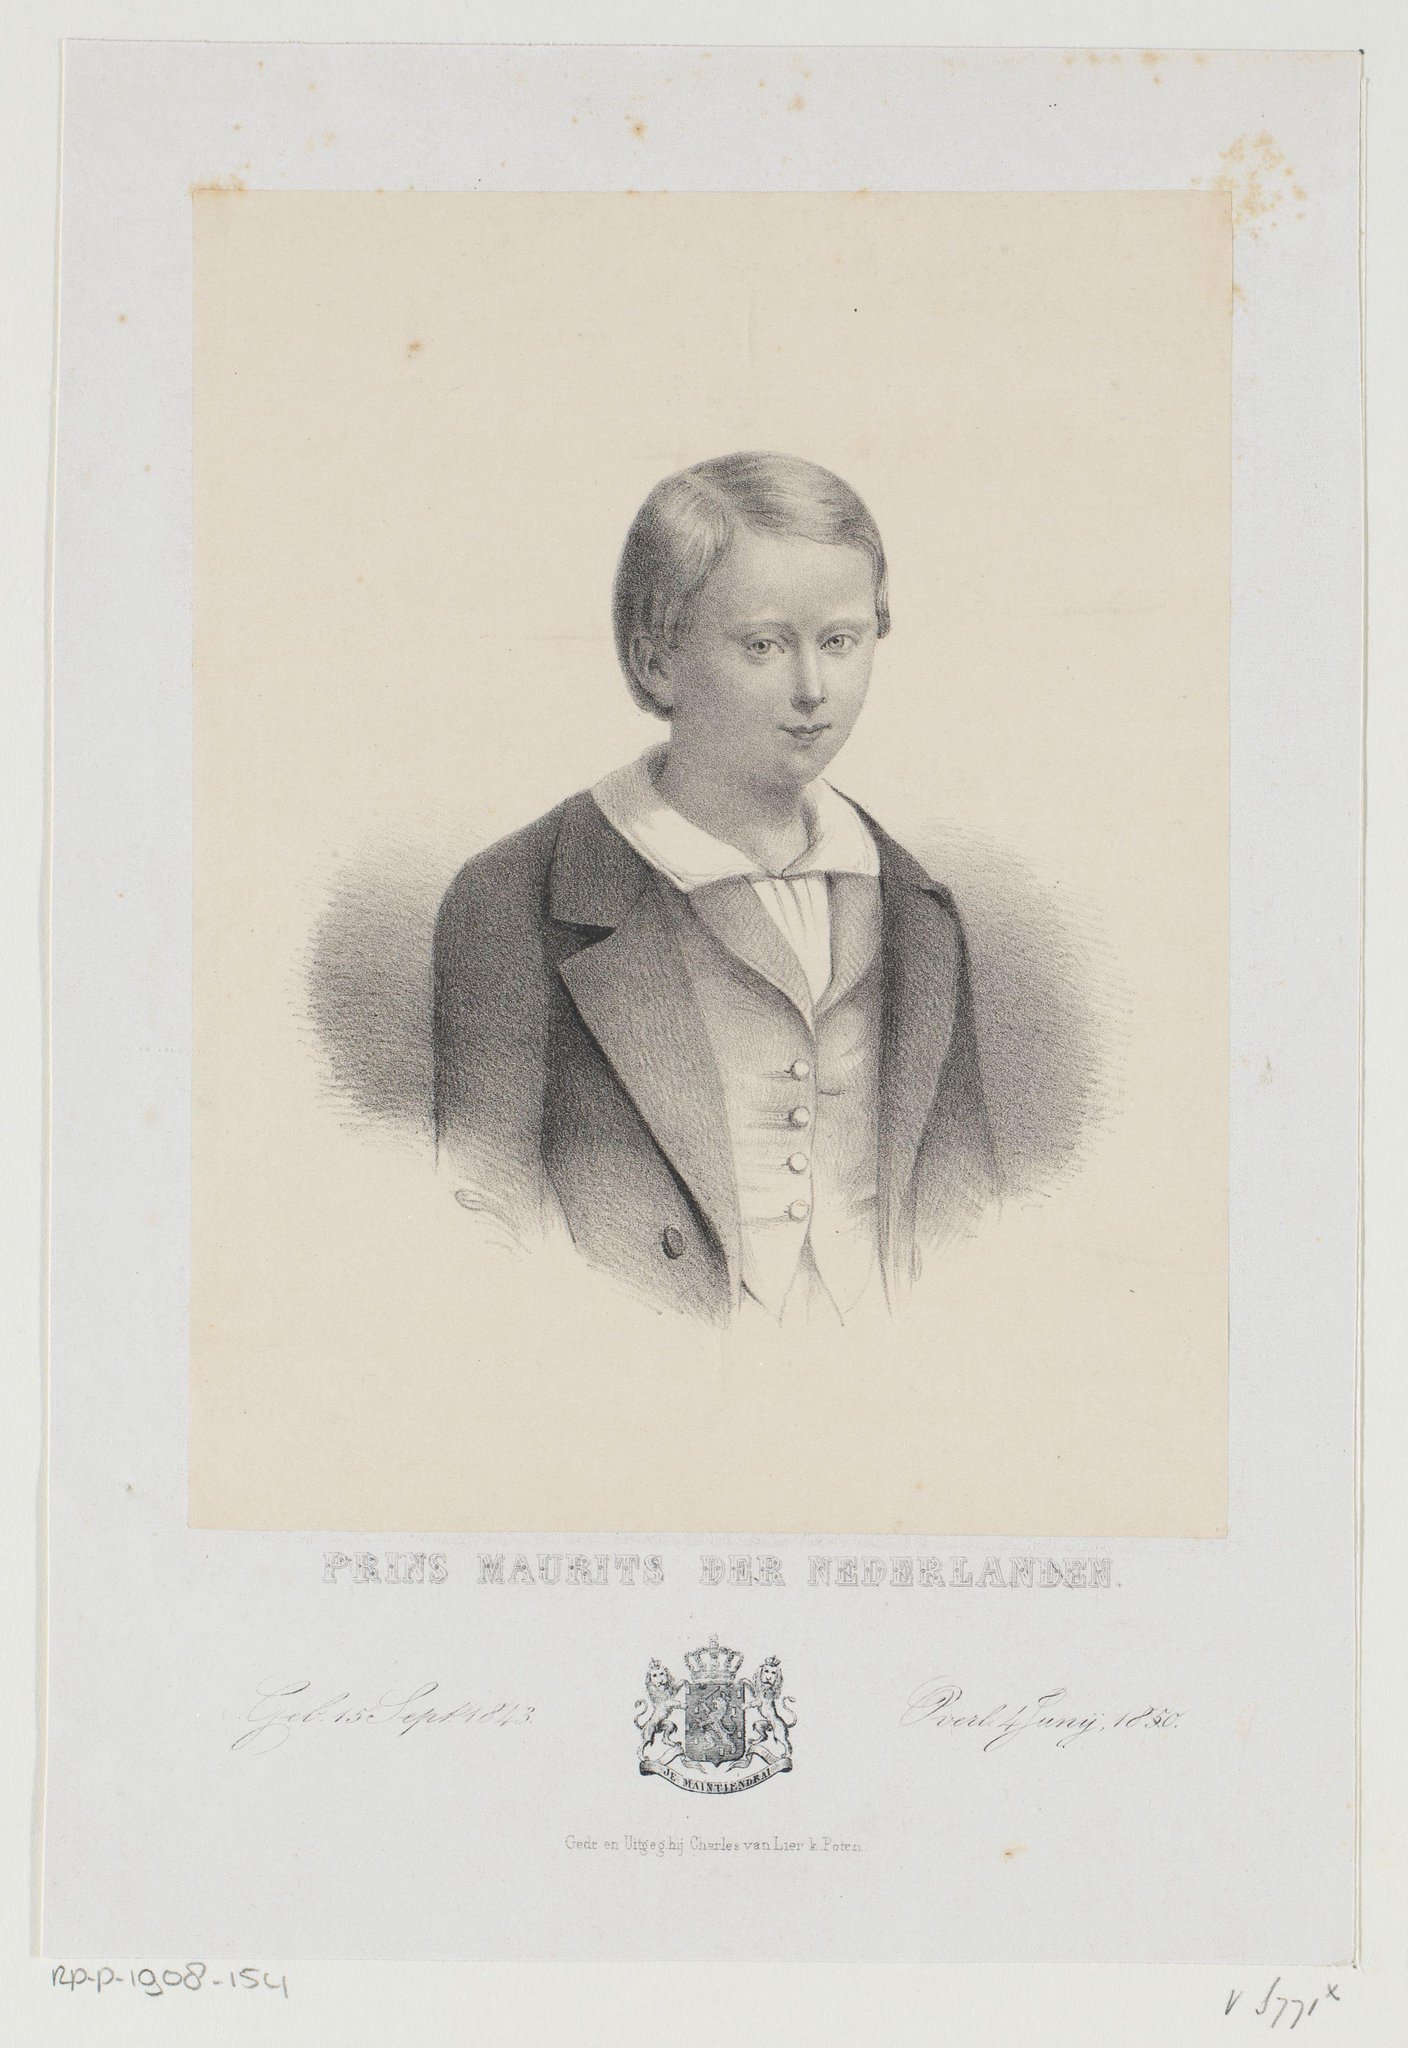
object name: print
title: Portret van Maurits, prins der Nederlanden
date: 1850-1882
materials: paper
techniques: lithograph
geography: netherlands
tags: the hague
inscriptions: collector's mark: Lugt 2228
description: Portret van Maurits. Midden onder zijn wapen met een kroon en twee leeuwen. Daaronder op een banderol zijn geslachtsspreuk. In de ondermarge zijn naam, titel, zijn geboortedatum en sterfdatum.